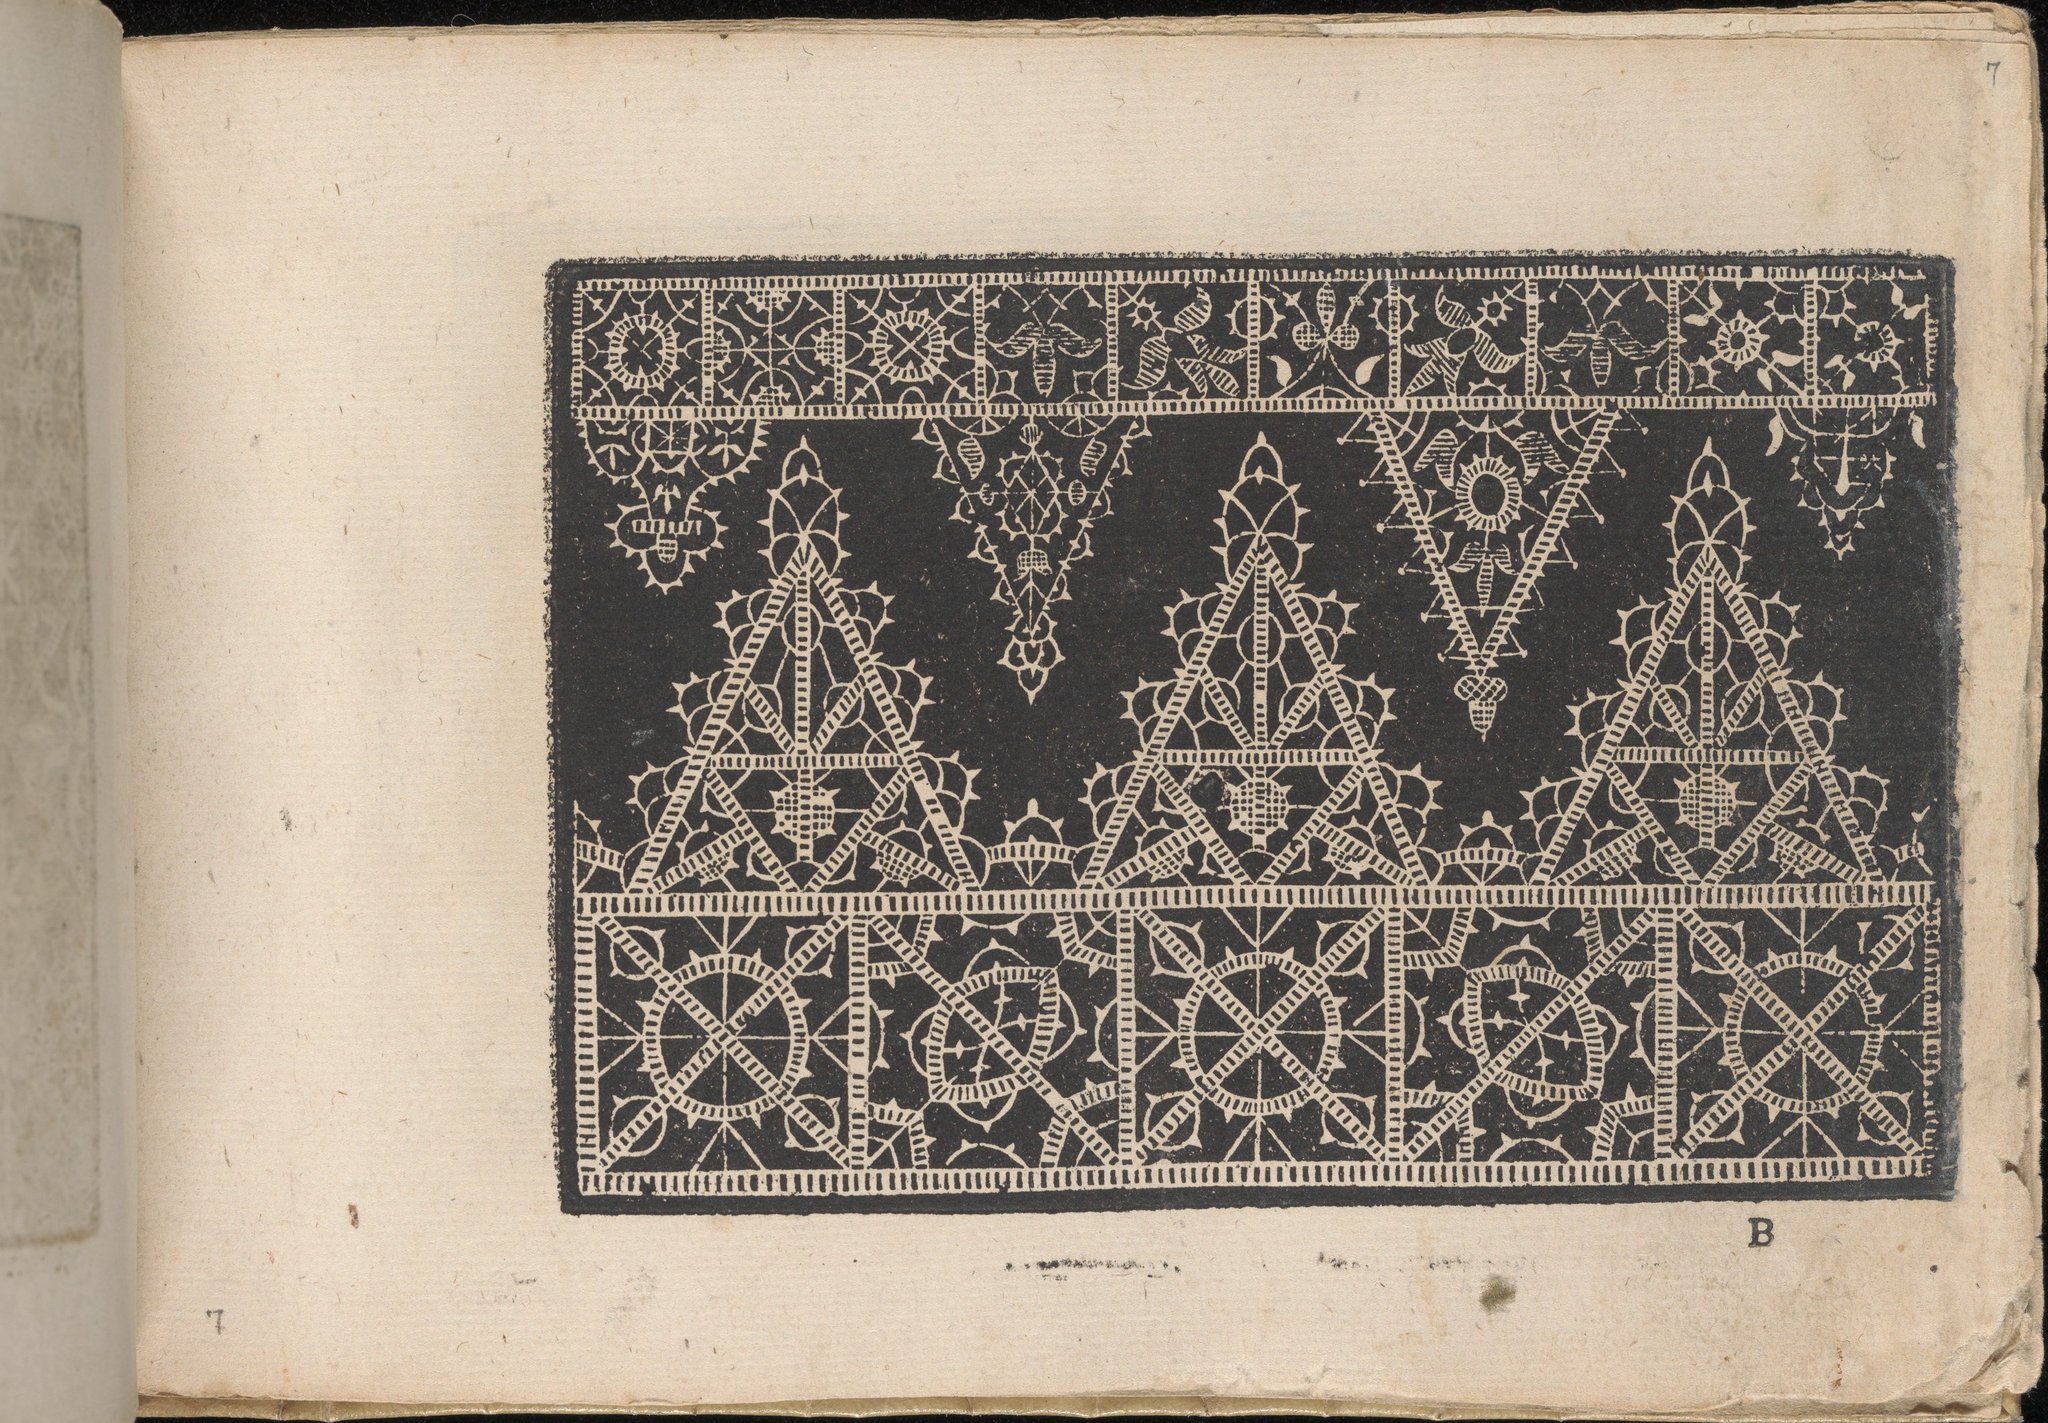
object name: book print ornament archiecture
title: Fiori di Ricami Nuovamente Posti in Luce, page 7 (recto)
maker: matteo florimi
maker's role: designer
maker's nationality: italian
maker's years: 1581-1613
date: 1591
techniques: woodcut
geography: italy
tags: ornament